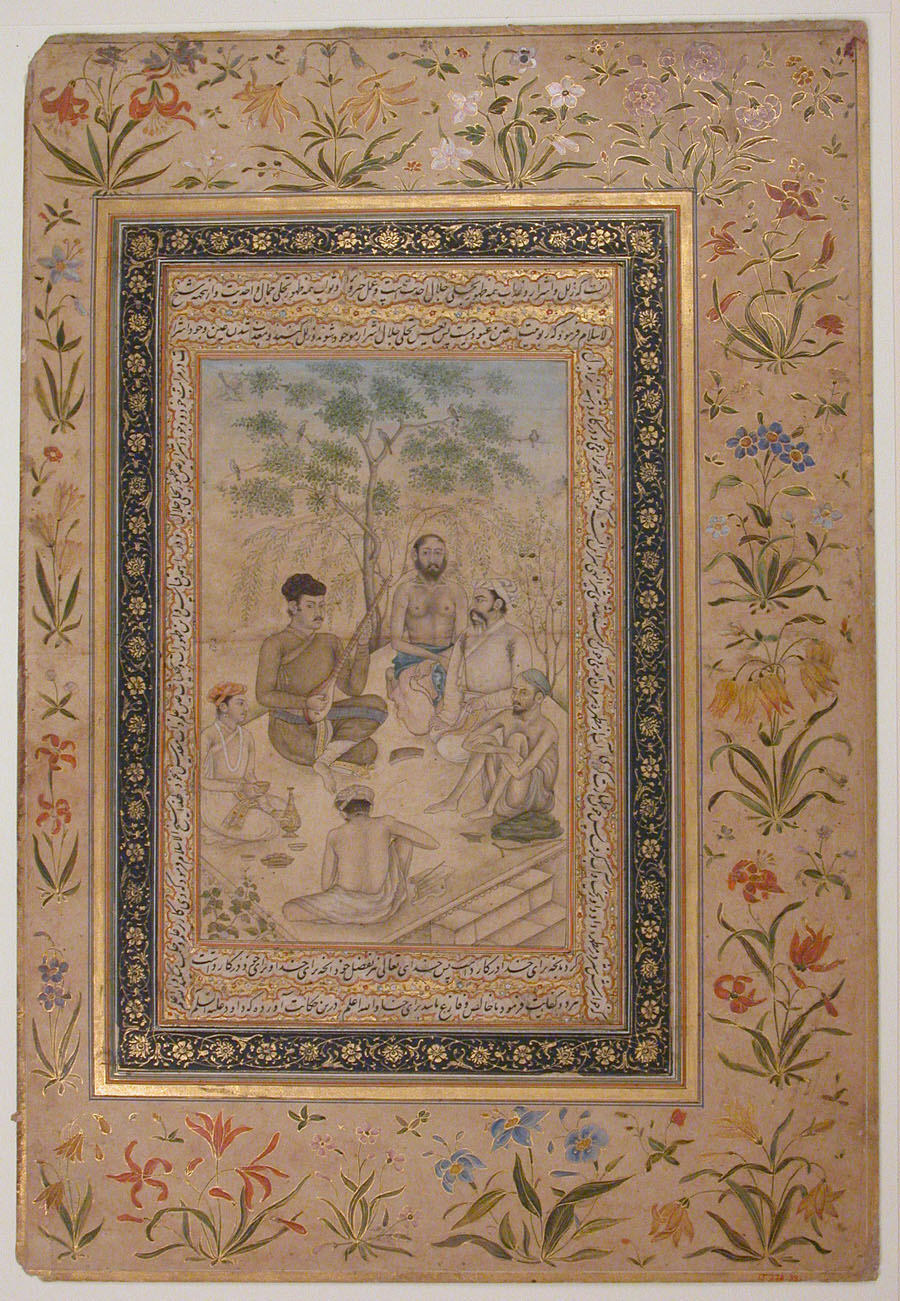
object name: illustrated album leaf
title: Visit to Holy Man by Prince Salim (Jahangir as a Youth?)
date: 1801-1900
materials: gold, ink, paper, watercolor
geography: india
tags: musical instruments,men,music